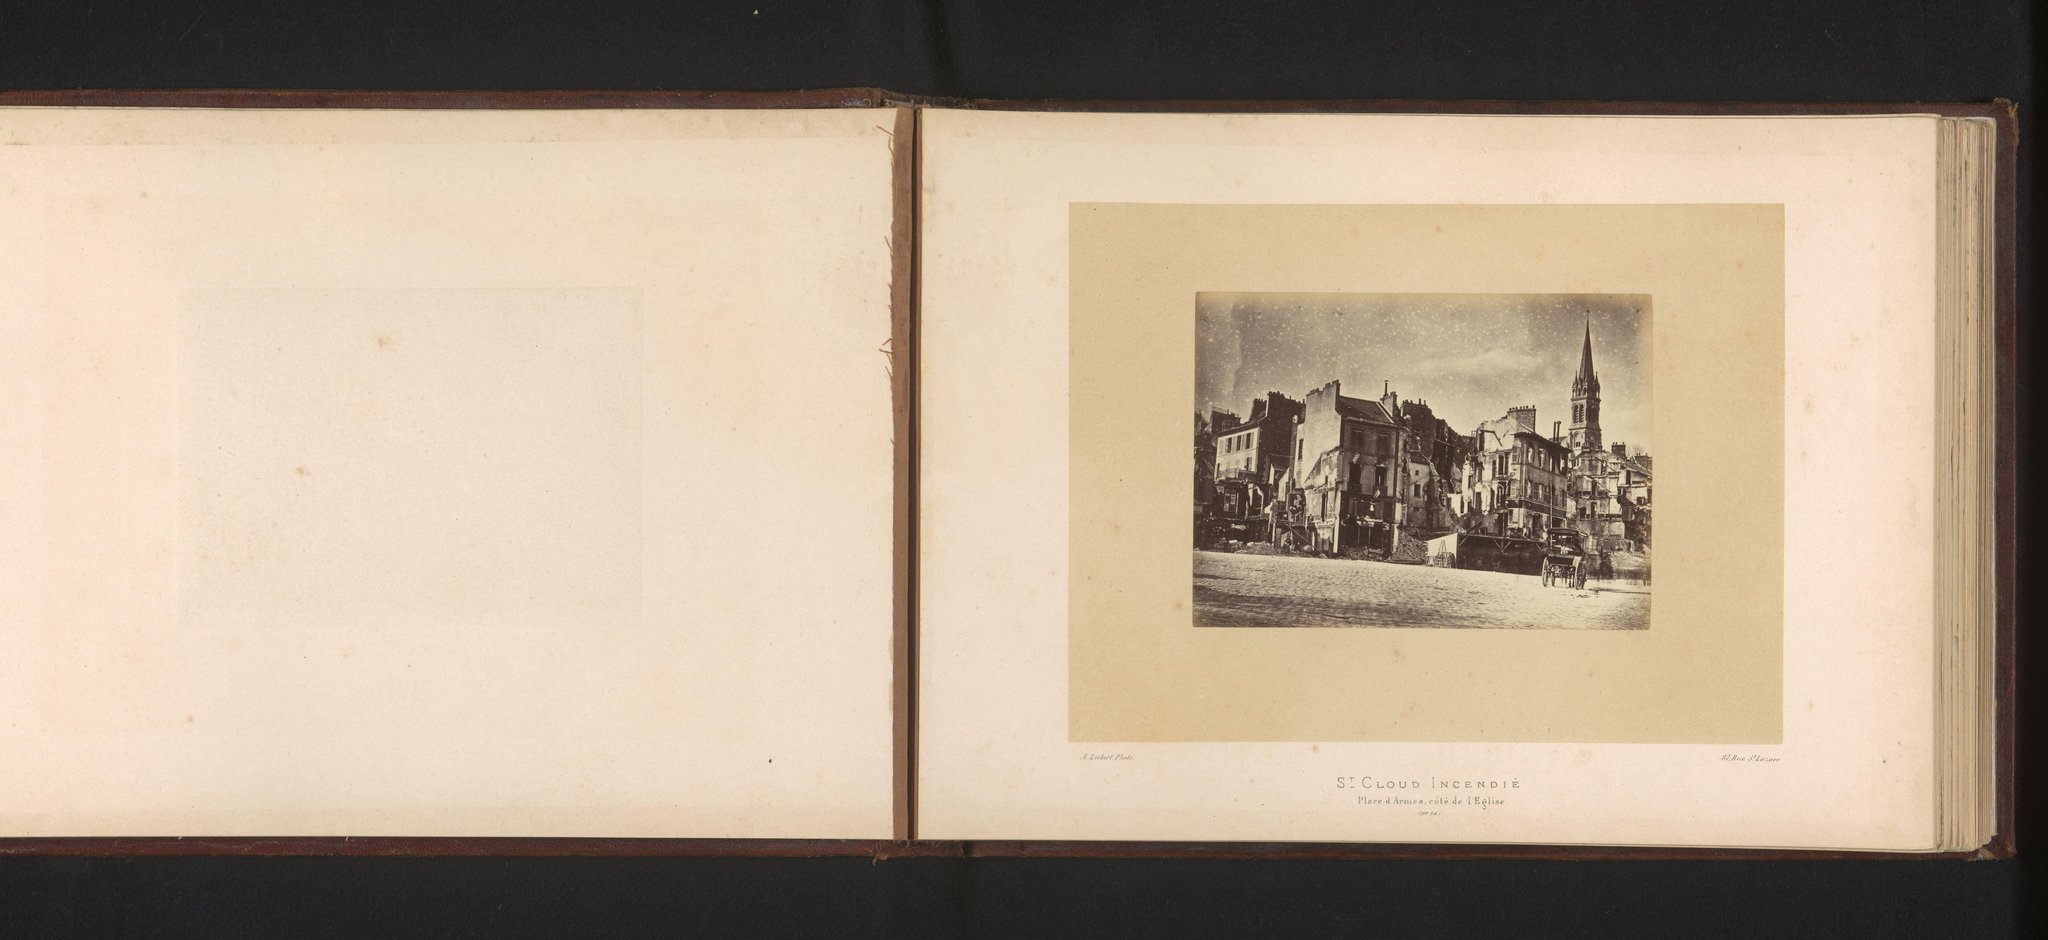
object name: page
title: St. Cloud Incendié. Place d'Armes, côté de l'Eglise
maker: alphonse-justin liébert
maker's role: fotograaf, marinier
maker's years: 1827-1914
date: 1871-1872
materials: photographic support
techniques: albumen print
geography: saint-cloud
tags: square, place, circus, etc., ruin of a building ~ architecture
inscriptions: number: ‘(No. 56)’, address: ‘31, Rue St. Lazare’